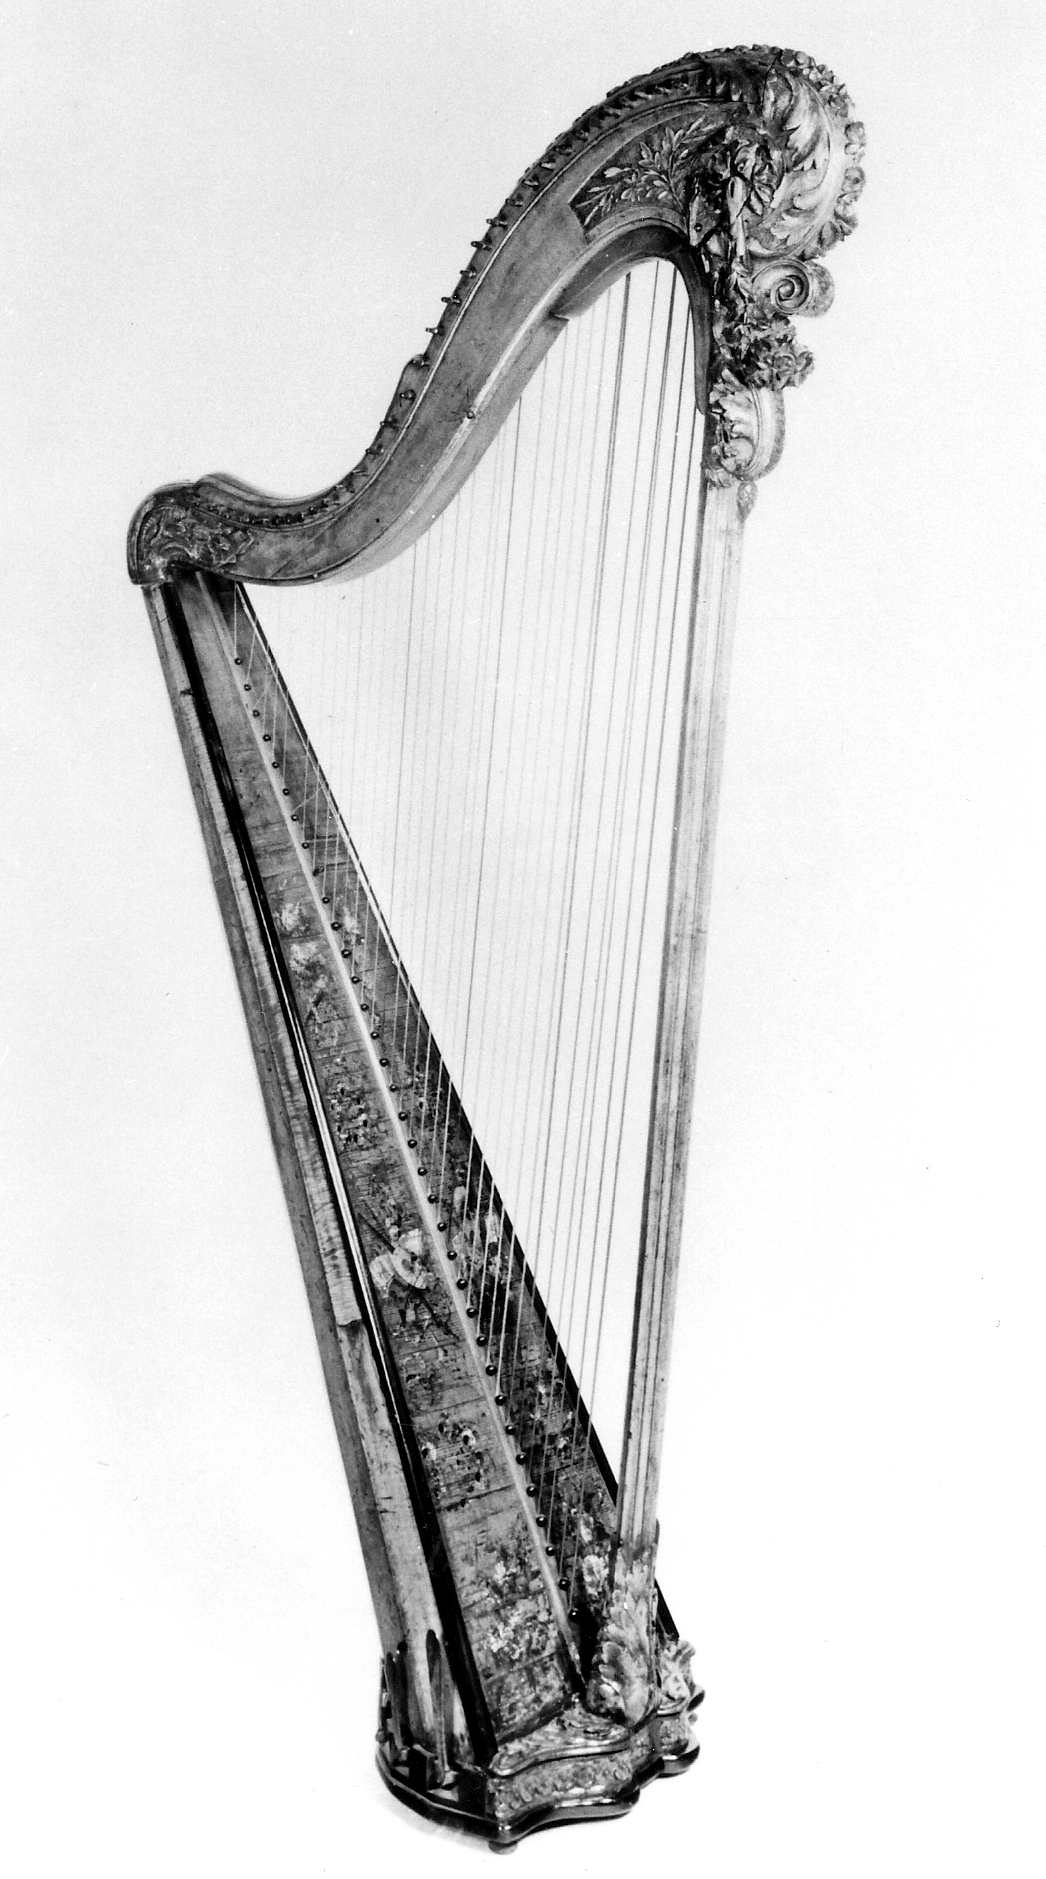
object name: pedal harp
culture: french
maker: holtzmann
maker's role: maker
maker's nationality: french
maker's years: 1736-1799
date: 1875-1900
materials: iron, paint, wood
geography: france